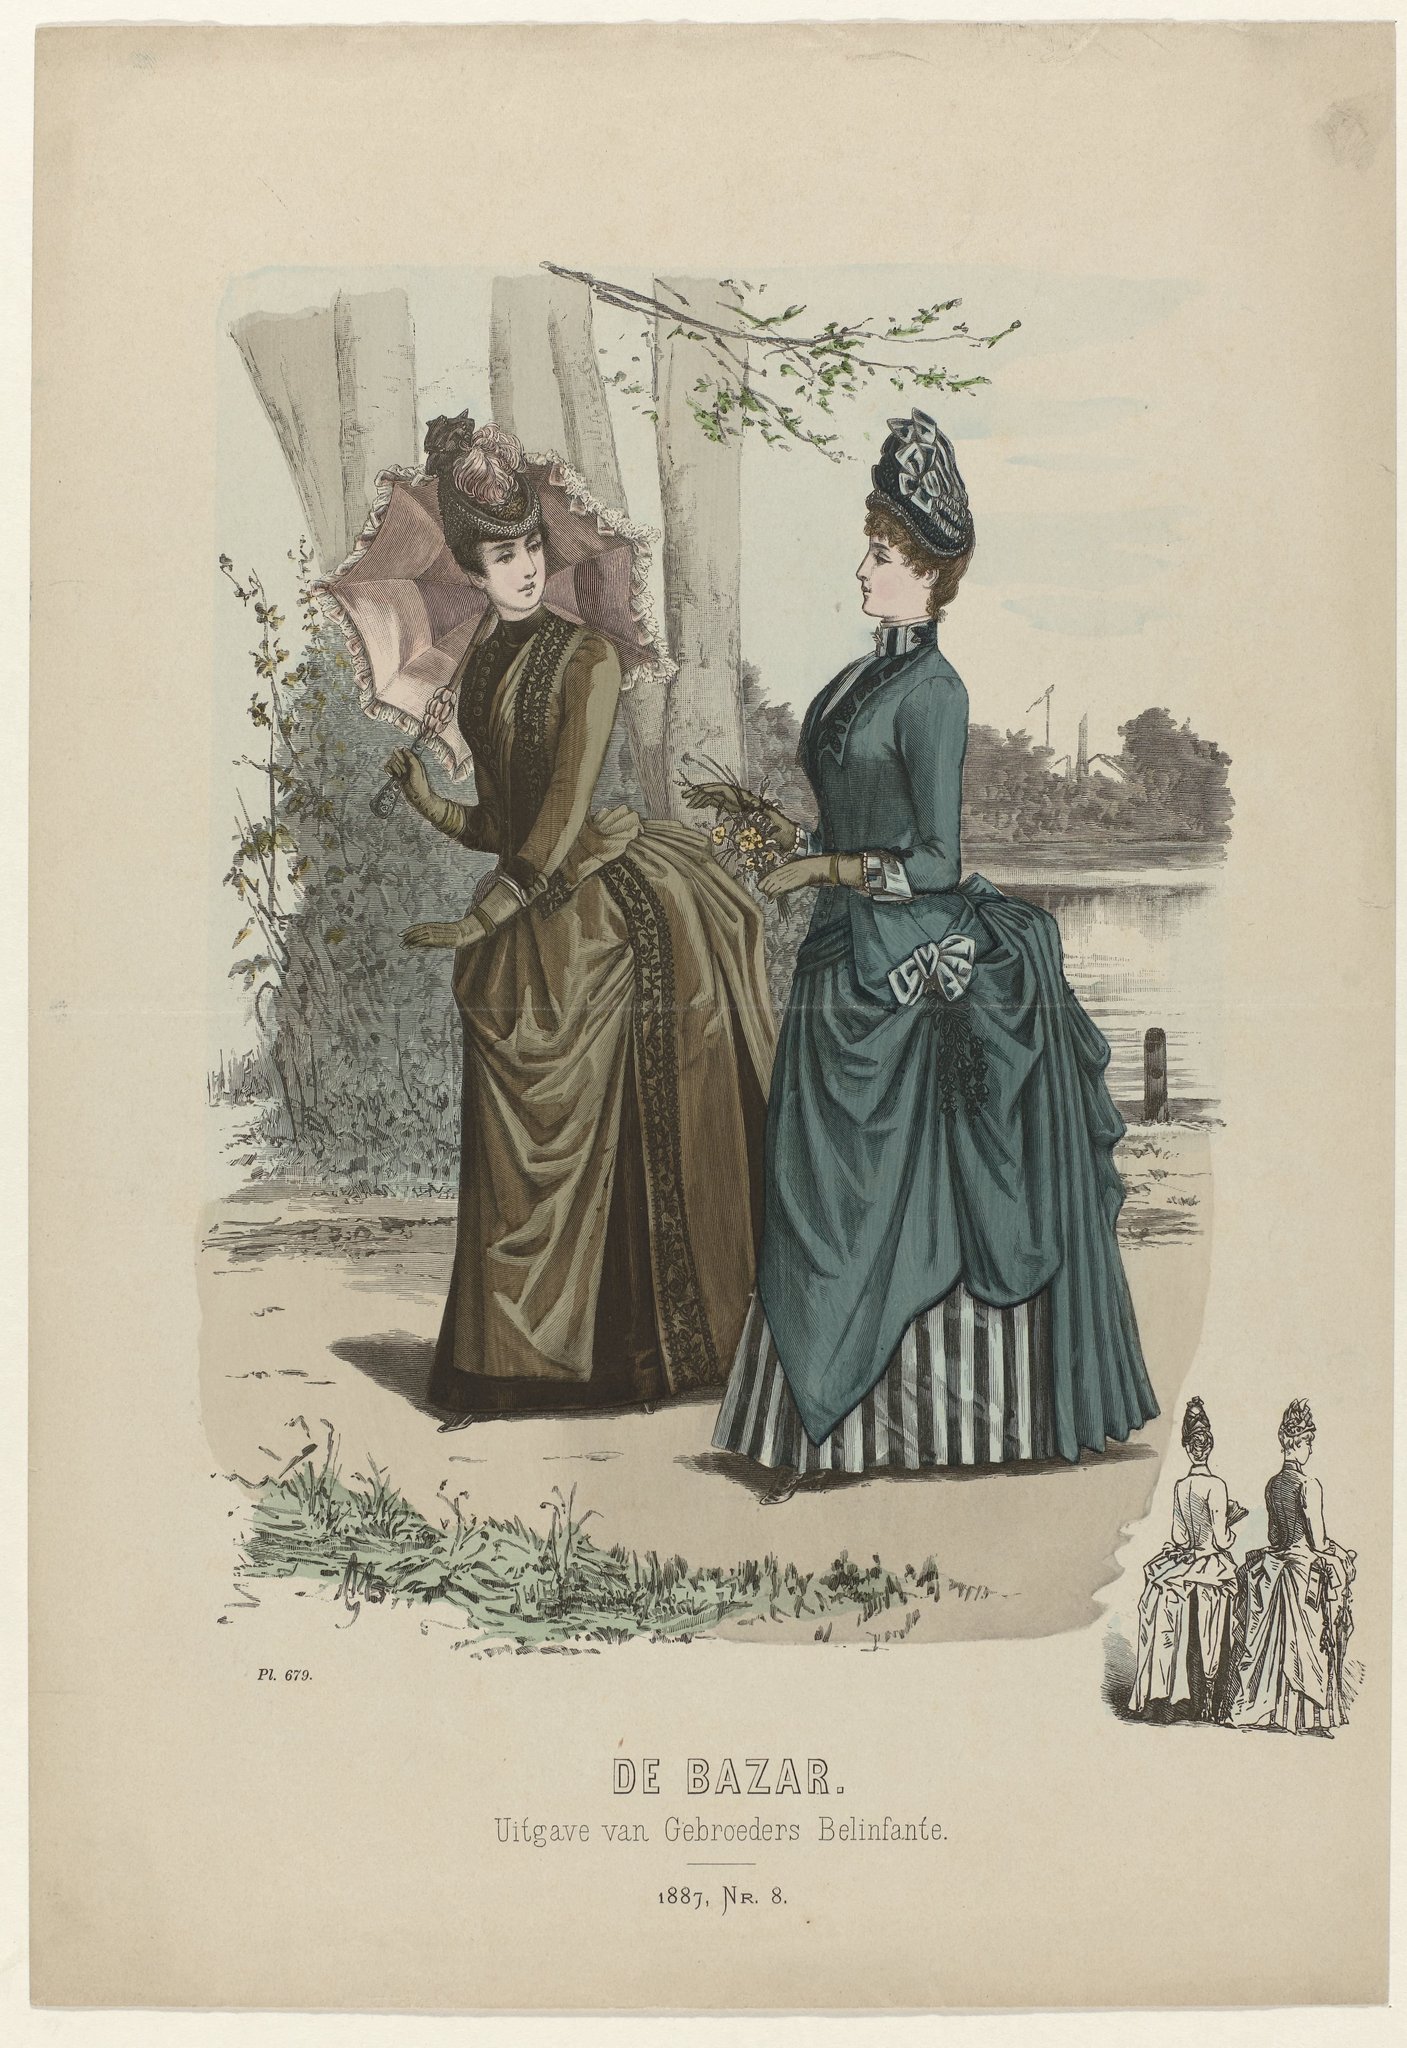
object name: fashion print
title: De Bazar, 1887, Nr. 8, Pl. 679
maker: Anonymous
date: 1887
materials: paper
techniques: hand coloring, engraving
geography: the hague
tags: cut flowers; nosegay, bunch of flowers, fashion plates, head-gear: hat (+ women's clothes), dress, gown (+ women's clothes), parasol, sunshade (+ women's clothes)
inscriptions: caption: ‘DE BAZAR. / Uitgave van Gebroeders Belinfante. / 1887, Nr. 8’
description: Prent uit het modetijdschrift De Bazar, geïllustreerd Tijdschrift voor Modes en Handwerken (1857-1900).